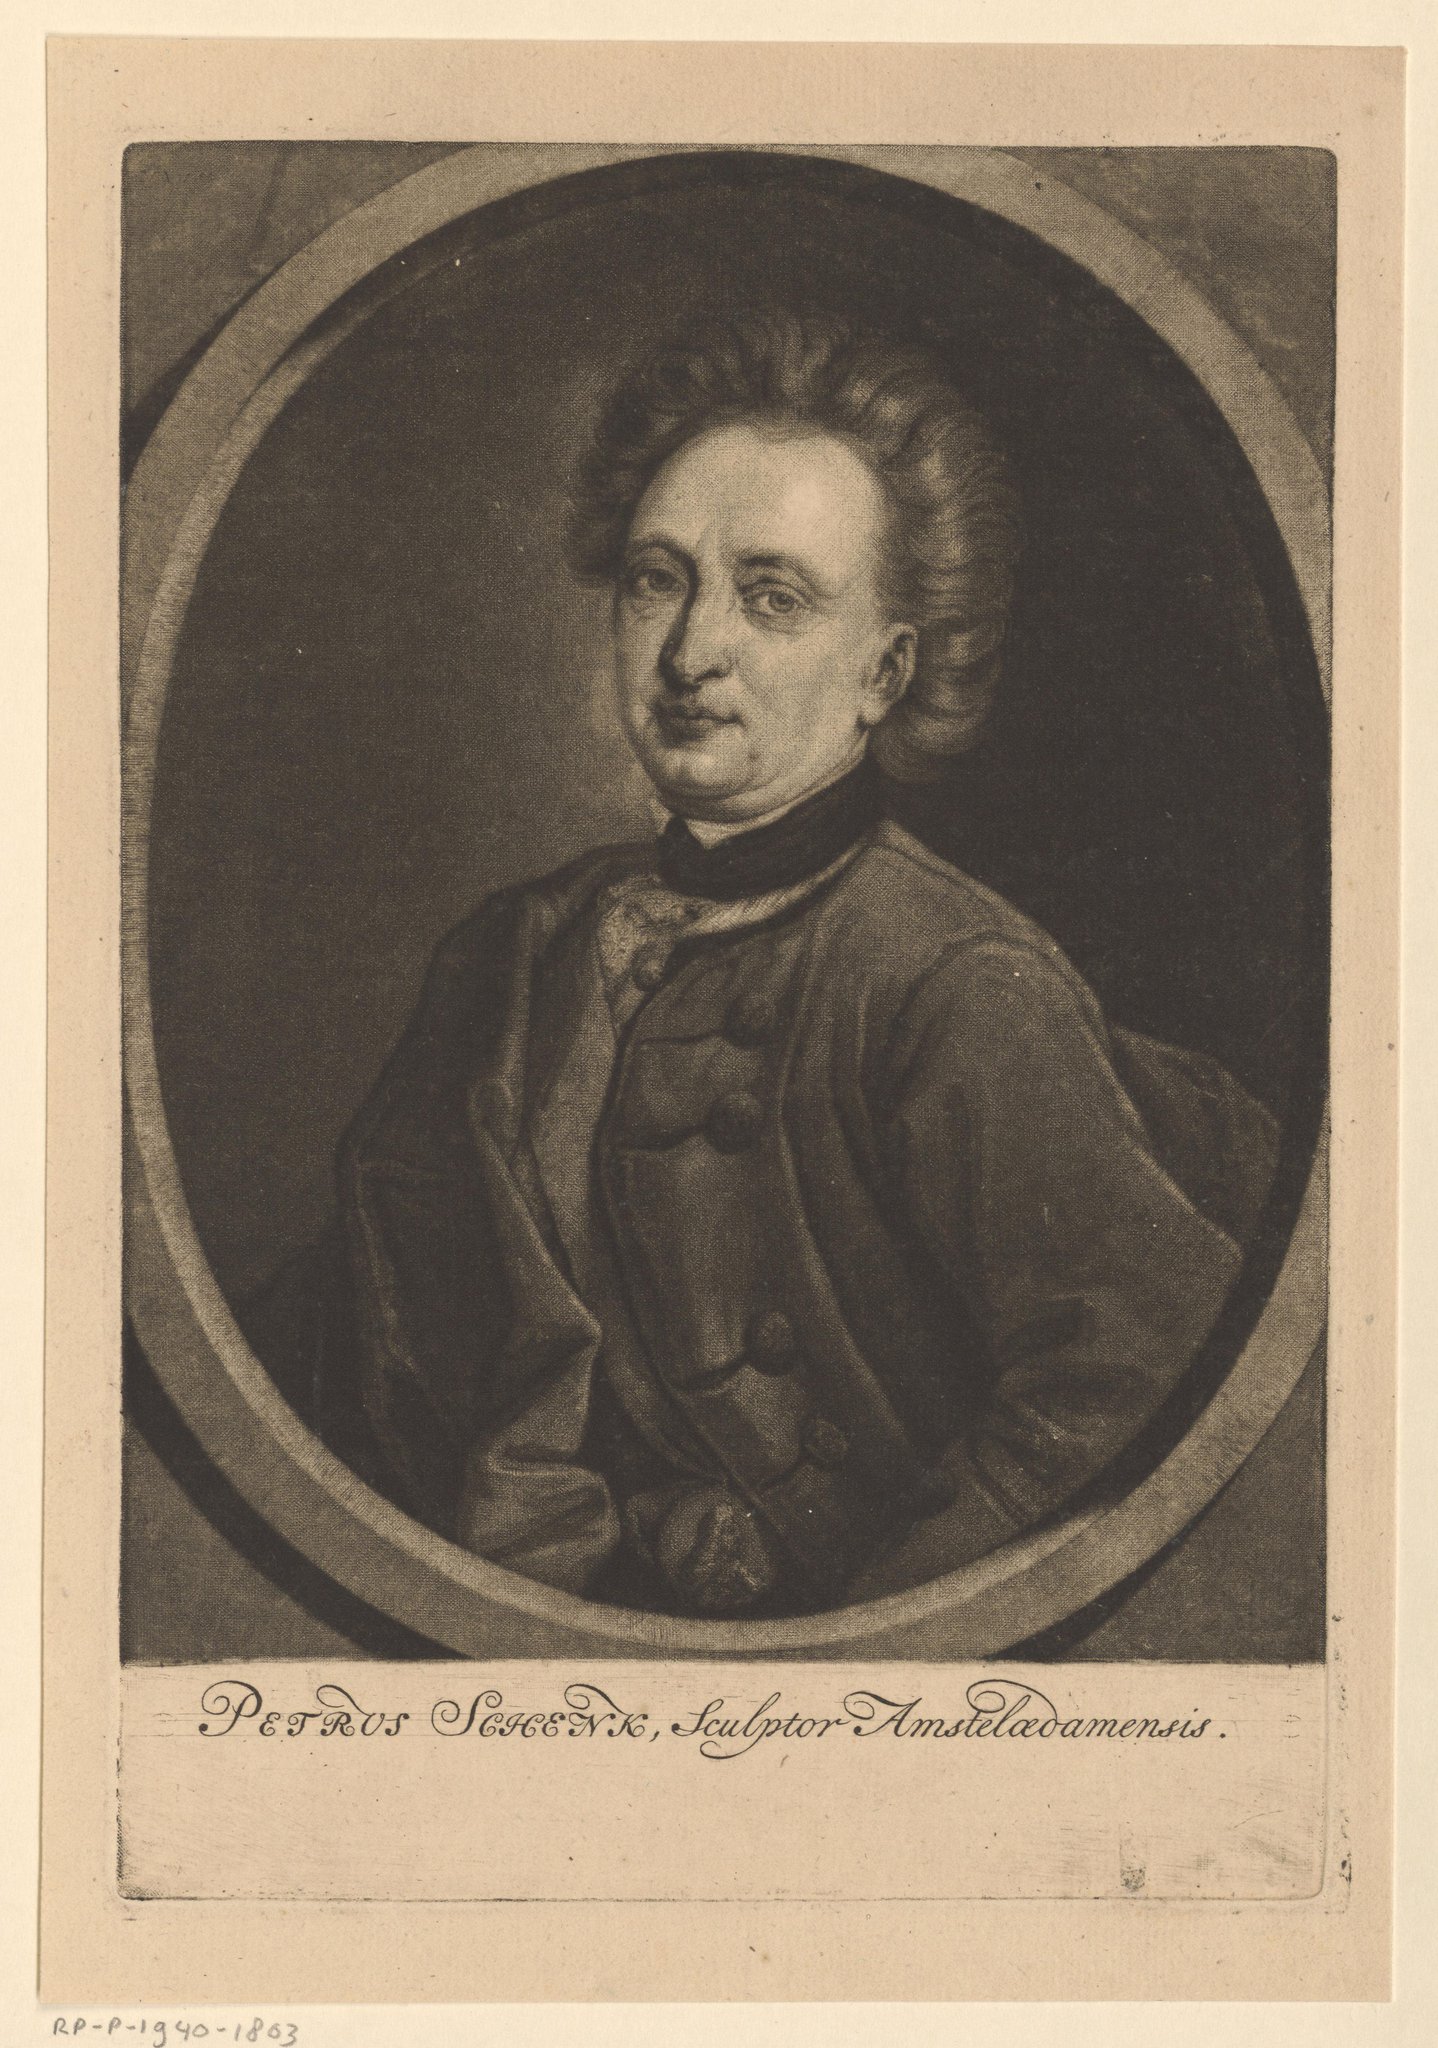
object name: print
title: Zelfportret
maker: pieter schenk (i)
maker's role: print maker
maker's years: 1660-1711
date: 1675-1711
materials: paper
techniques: engraving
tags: pieter schenk (i), historical persons, portrait, self-portrait of painter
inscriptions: collector's mark: Lugt 2760, collector's mark: Lugt 2228